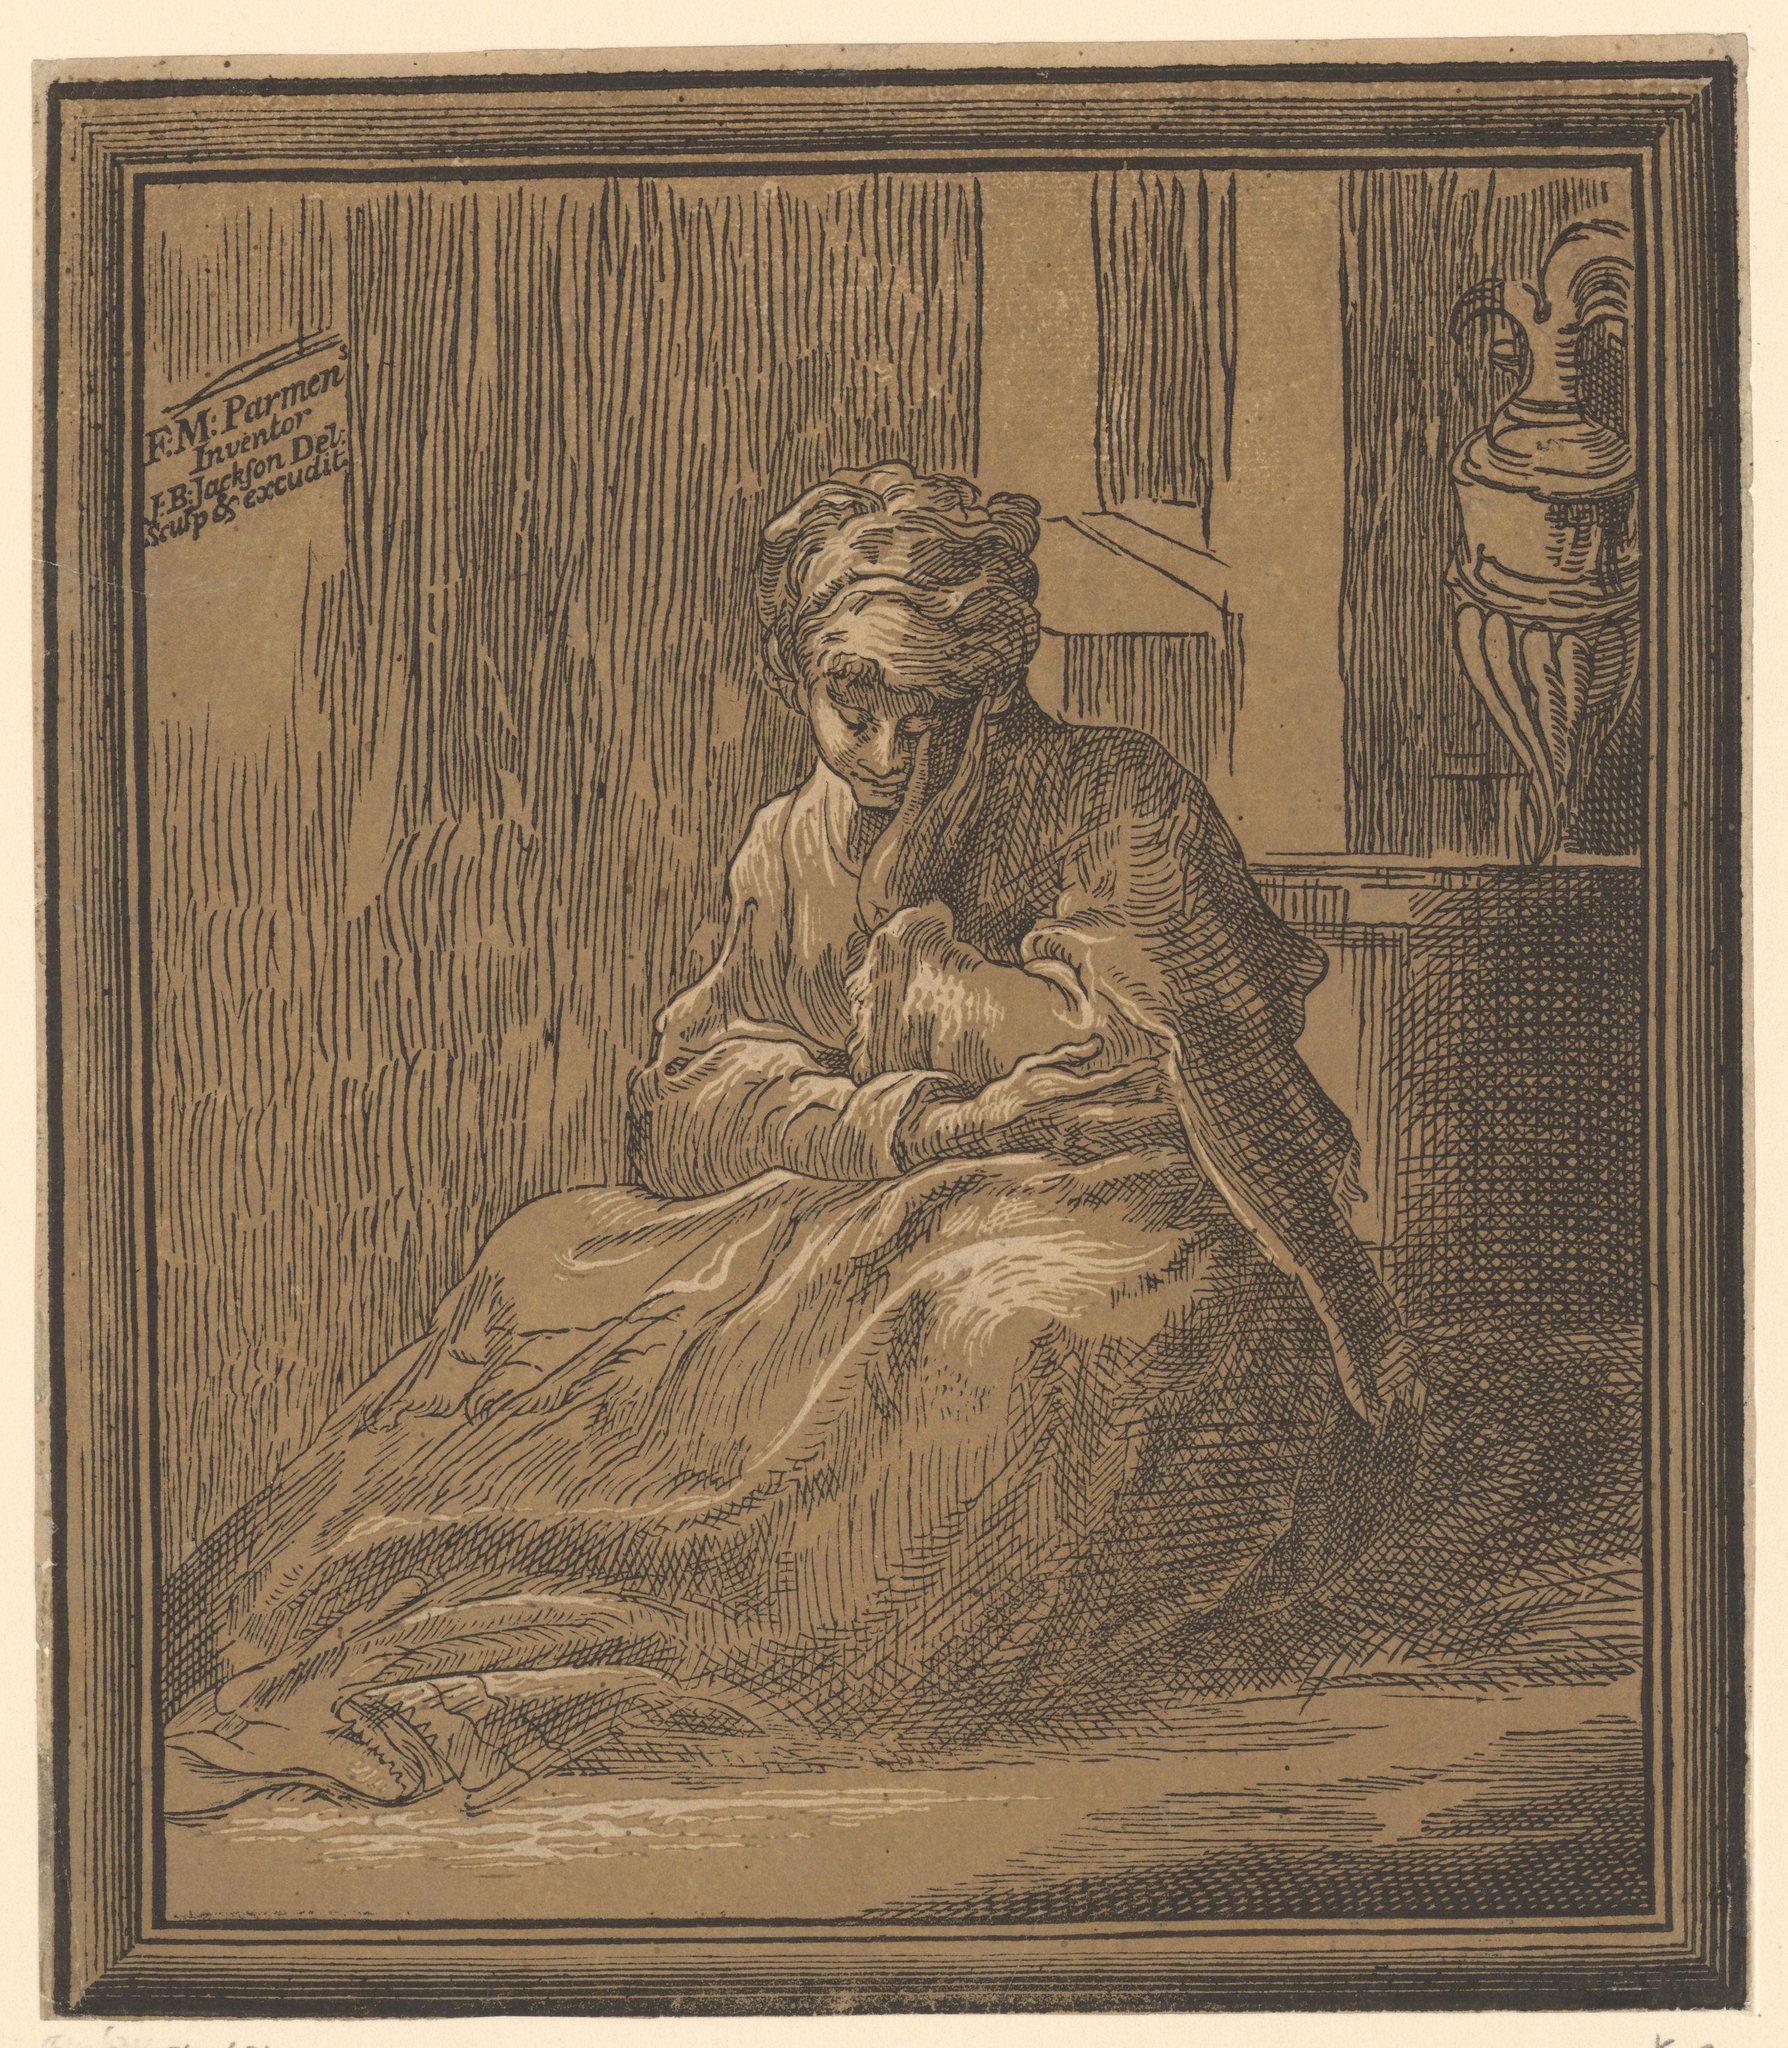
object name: print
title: Peinzende vrouw gezeten op de grond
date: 1711-1780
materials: paper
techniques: woodcut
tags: adult woman, postures and gestures of arms and hands in relation to the head, sitting on the ground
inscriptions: collector's mark: Lugt 2760, collector's mark: Lugt 2228